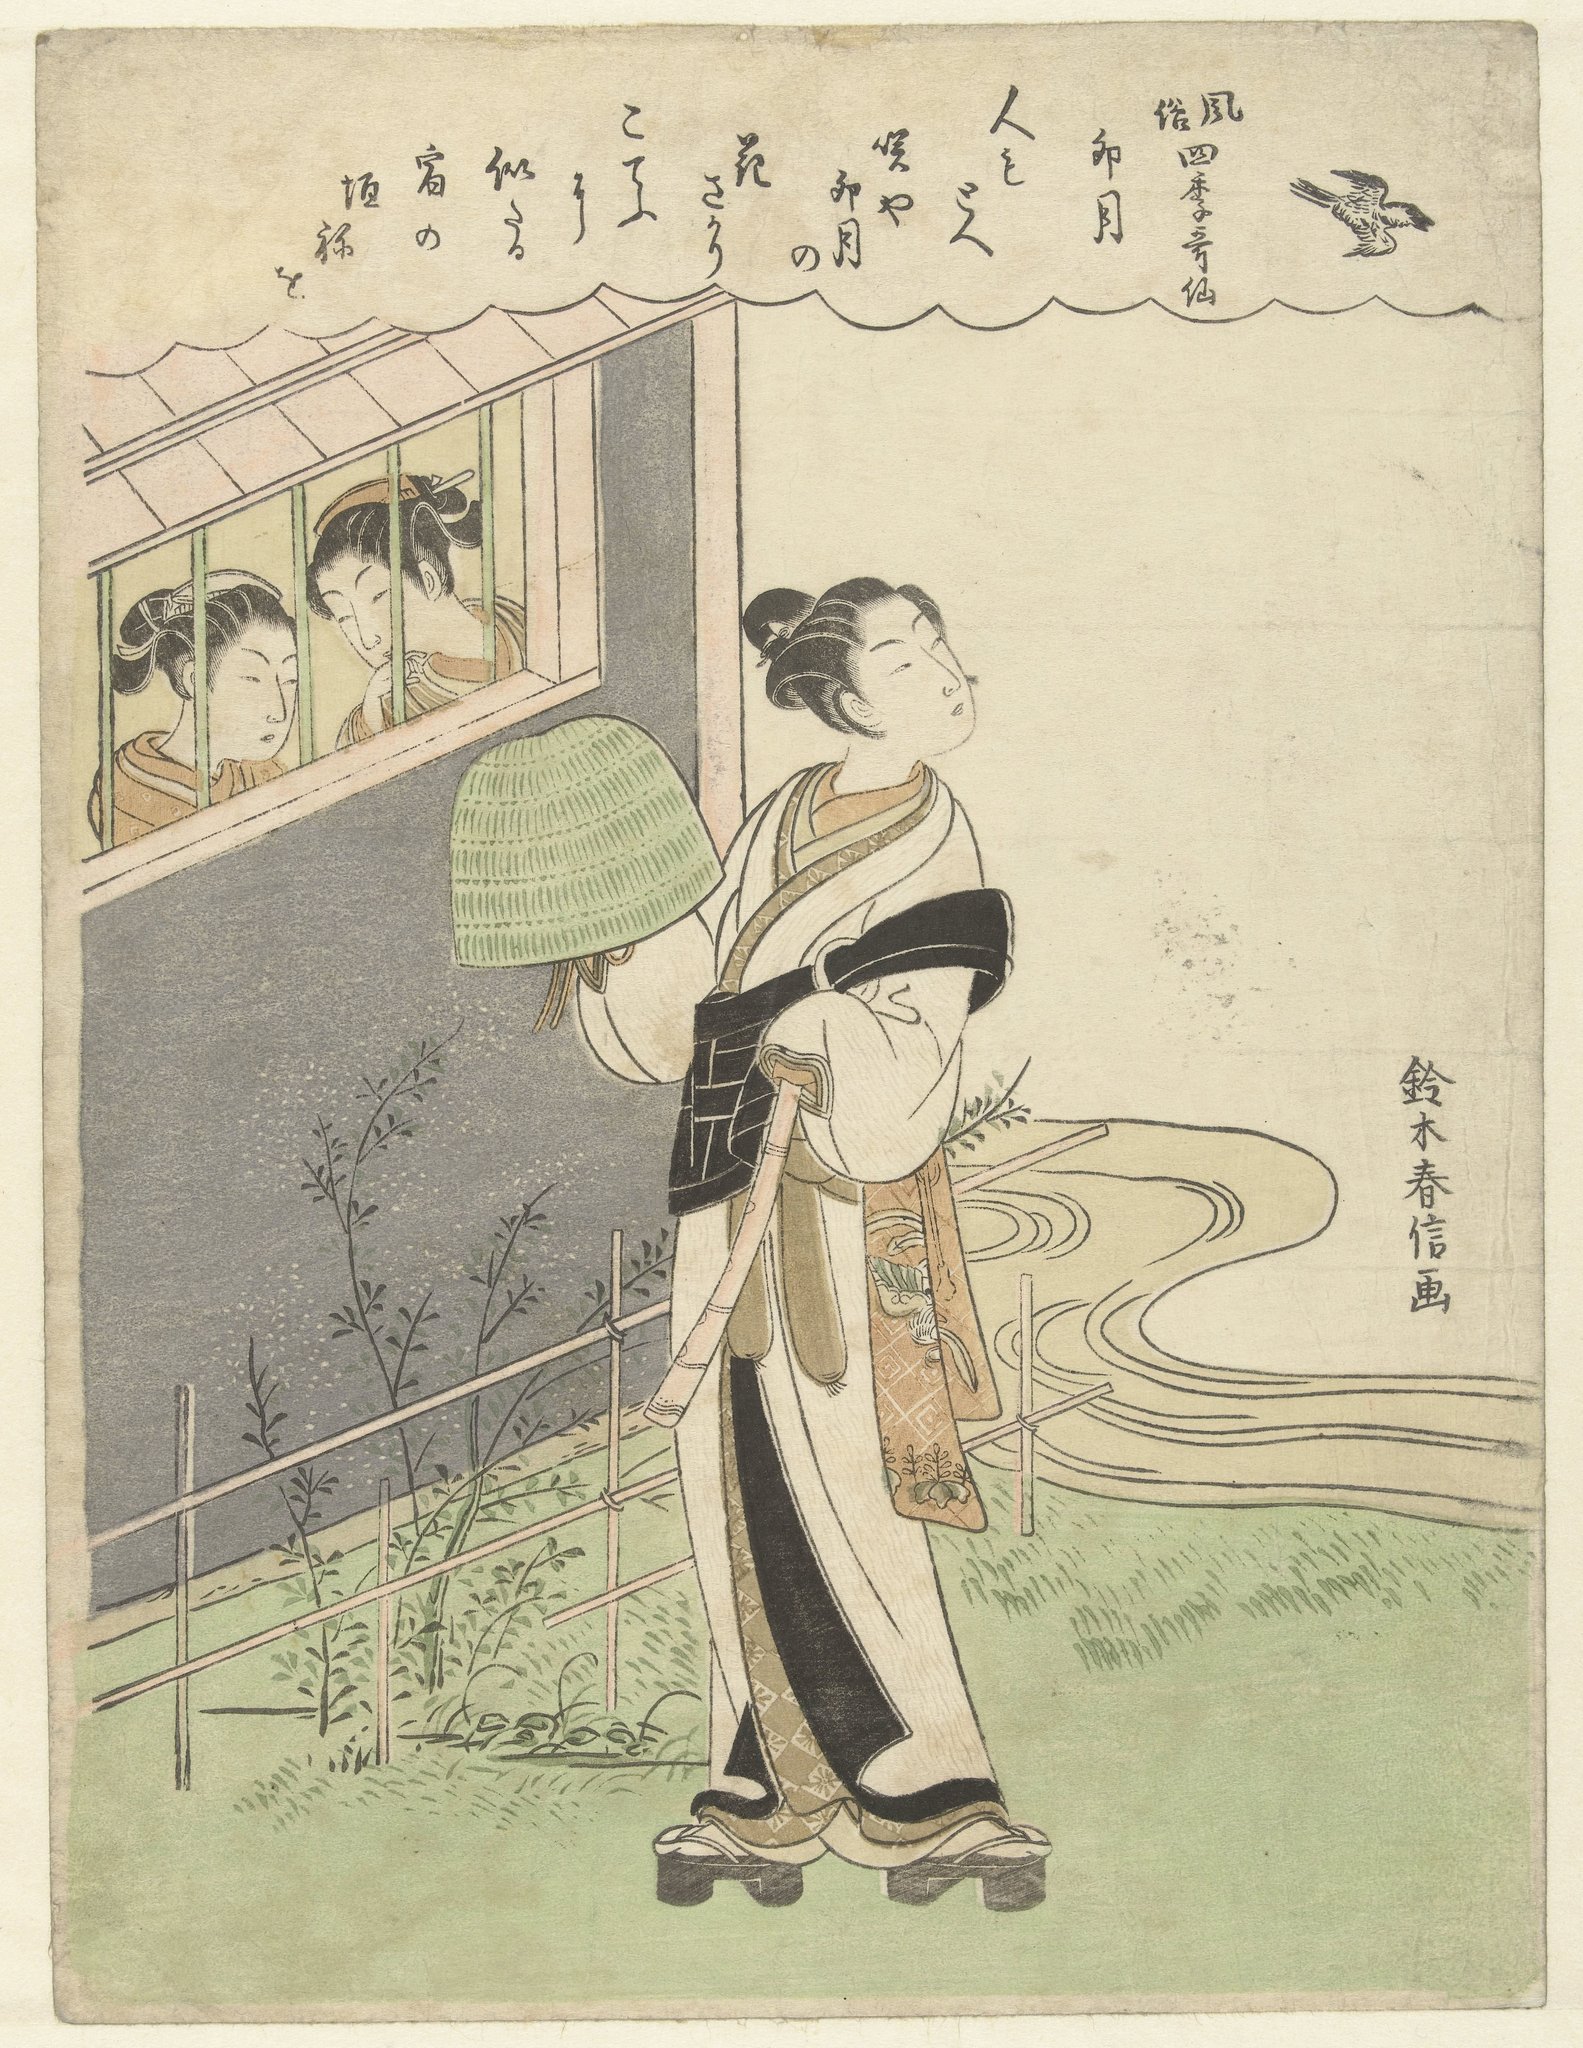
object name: print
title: Uzuki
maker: suzuki harunobu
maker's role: print maker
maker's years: 1725-1770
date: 1765-1770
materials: paper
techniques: blind stamped, woodcut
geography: japan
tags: head-gear, adult man, flute, aulos, tibia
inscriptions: inscription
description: Man (komuso) met hoed in rechter en fluit in linker hand, staand bij bamboe hekje en rivier, opkijkend naar koekoek, terwijl twee meisjes hem vanachter een raam gade slaan. Een gedicht in een wolkvormig cartouche langs de bovenkant van de prent.